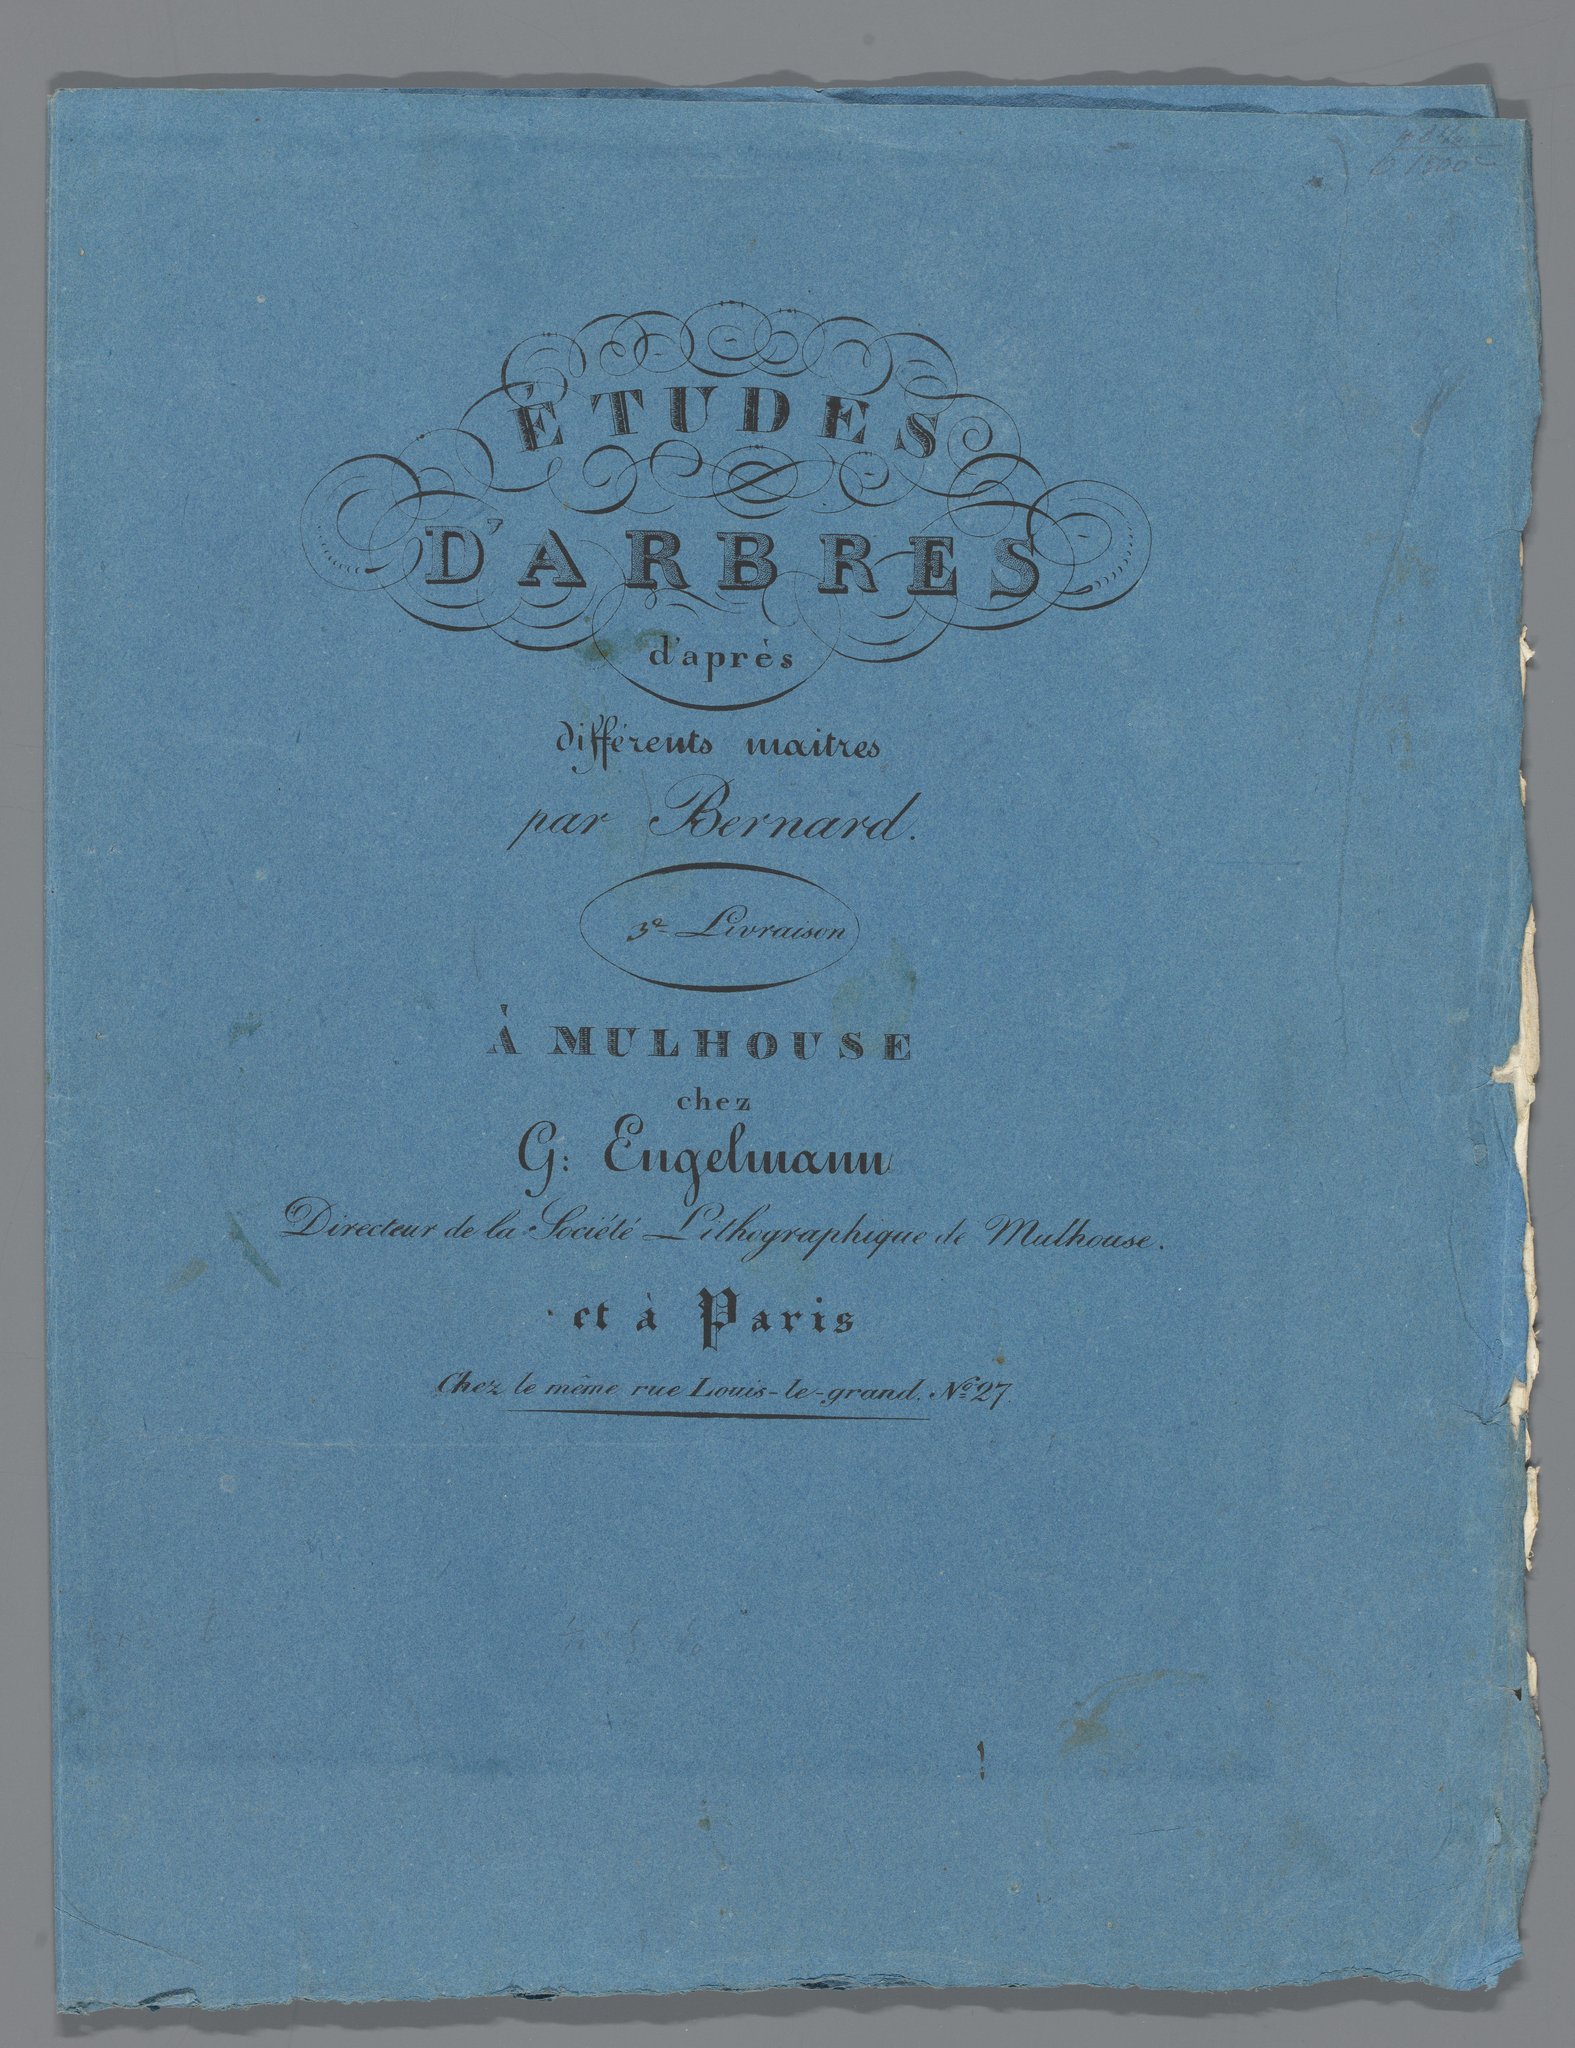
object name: wrapper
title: Études d'arbres d'après différents maitres par Bernard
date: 1820-1835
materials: paper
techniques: lithograph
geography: mulhouse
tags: trees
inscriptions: number: ‘6; [...]; 1500,-’, collector's mark: Lugt 2228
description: Omslag voor negen prenten, nummers zestien tot en met vierentwintig. Derde Livraison.